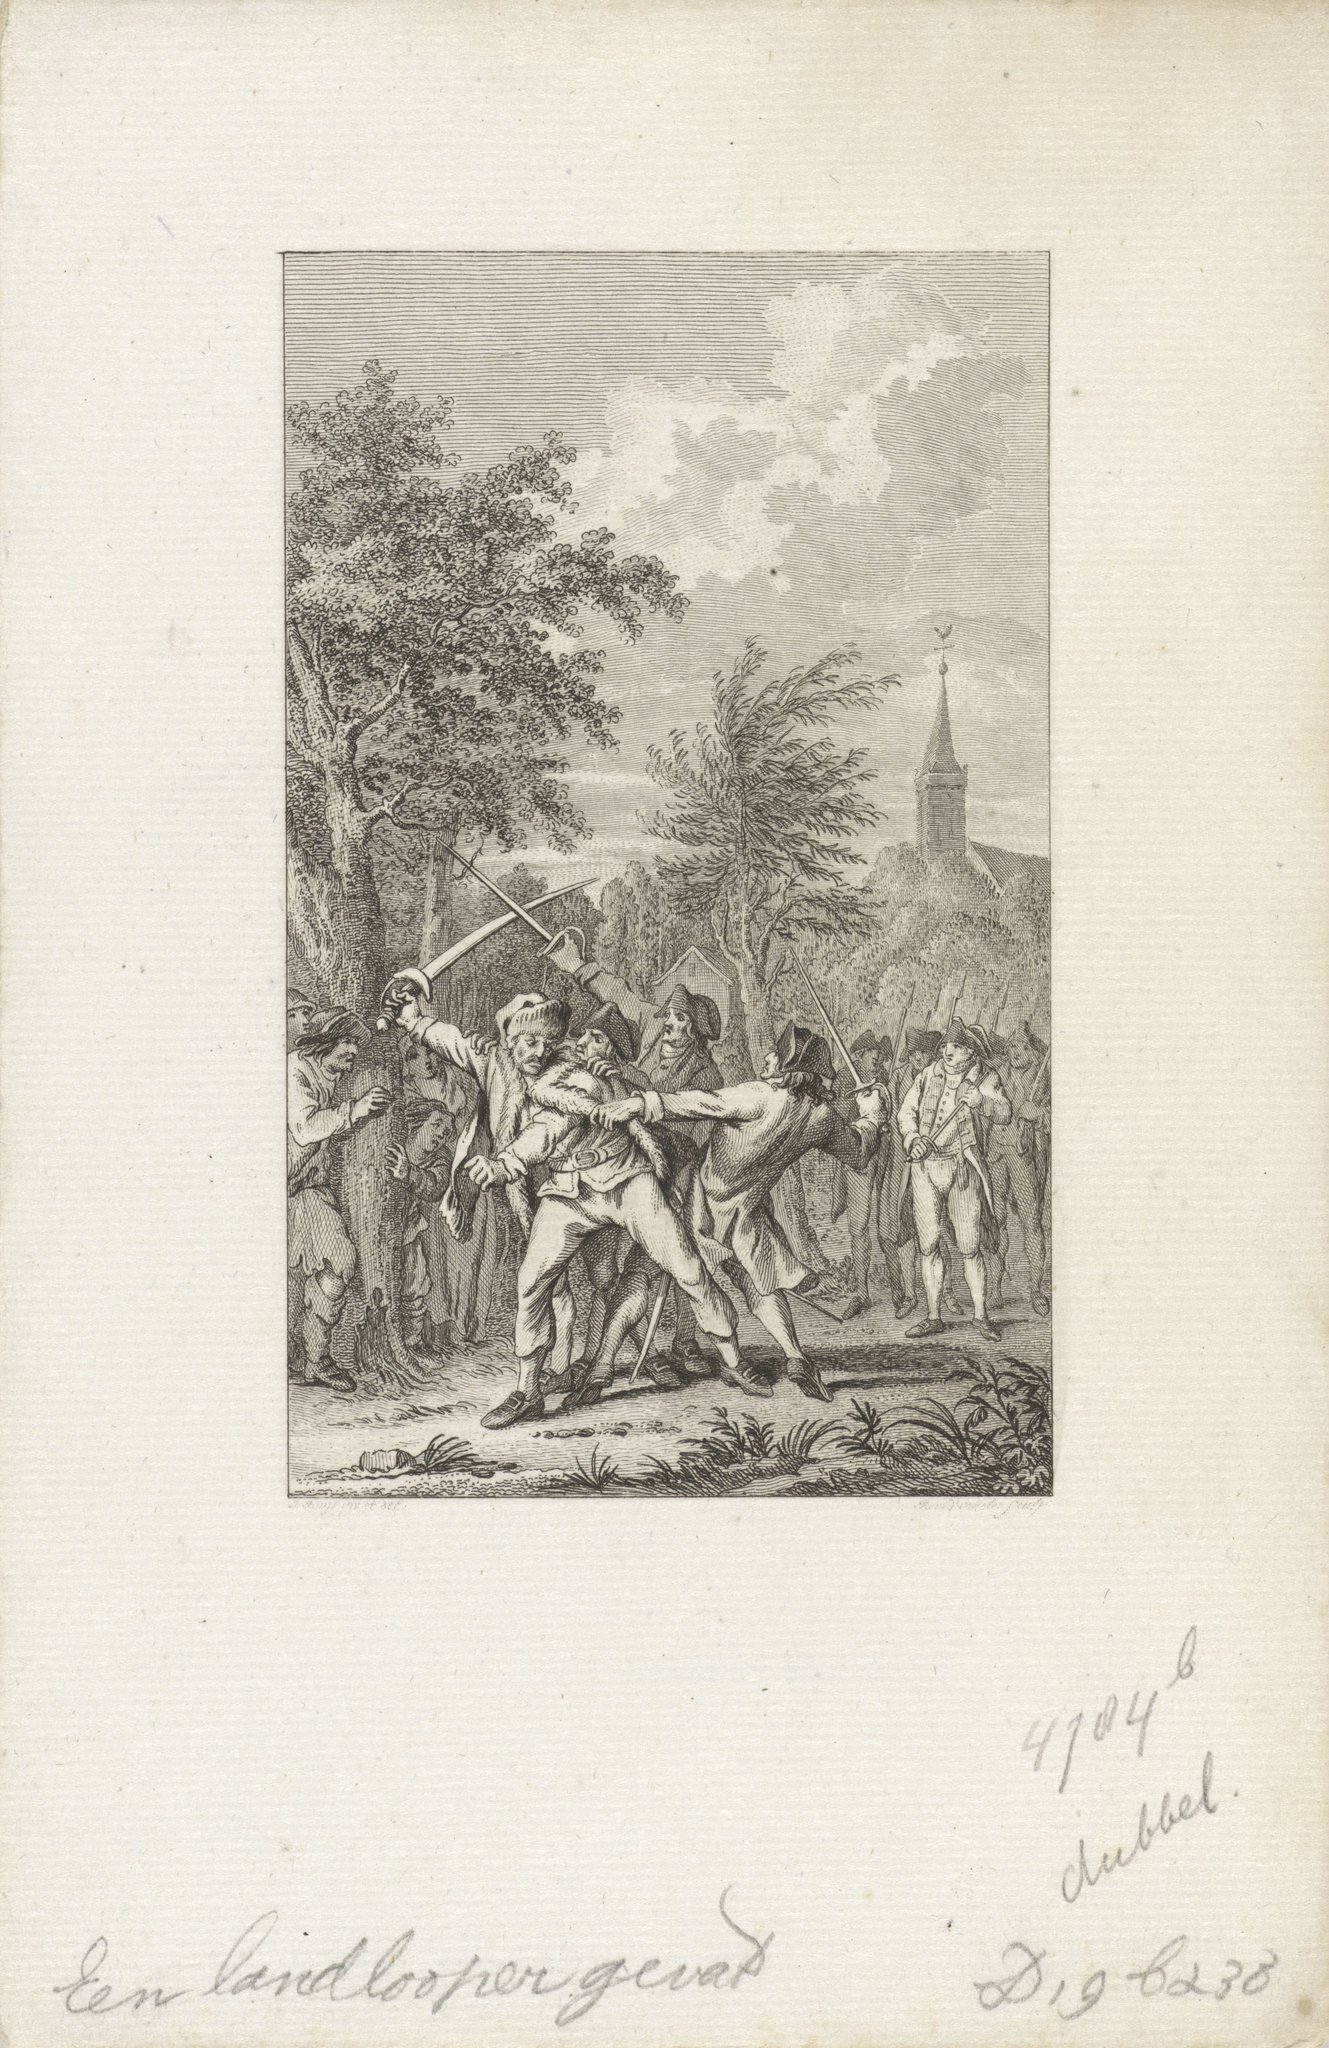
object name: history print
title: Aanhouding van een oproerkraaier in de Ommelanden, 1787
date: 1797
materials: paper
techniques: engraving, etching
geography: amsterdam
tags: arrest (of criminal), patriots (1780-1795)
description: Gebruikt als illustratie in: P.A. Loosjes. Vaderlandsche historie, vervattende de geschiedenissen, der Vereenigde Nederlanden (...). Ten onmiddelyken vervolge van Wagenaar's Vaderlandsche historie. Amsterdam: Johannes Allart.